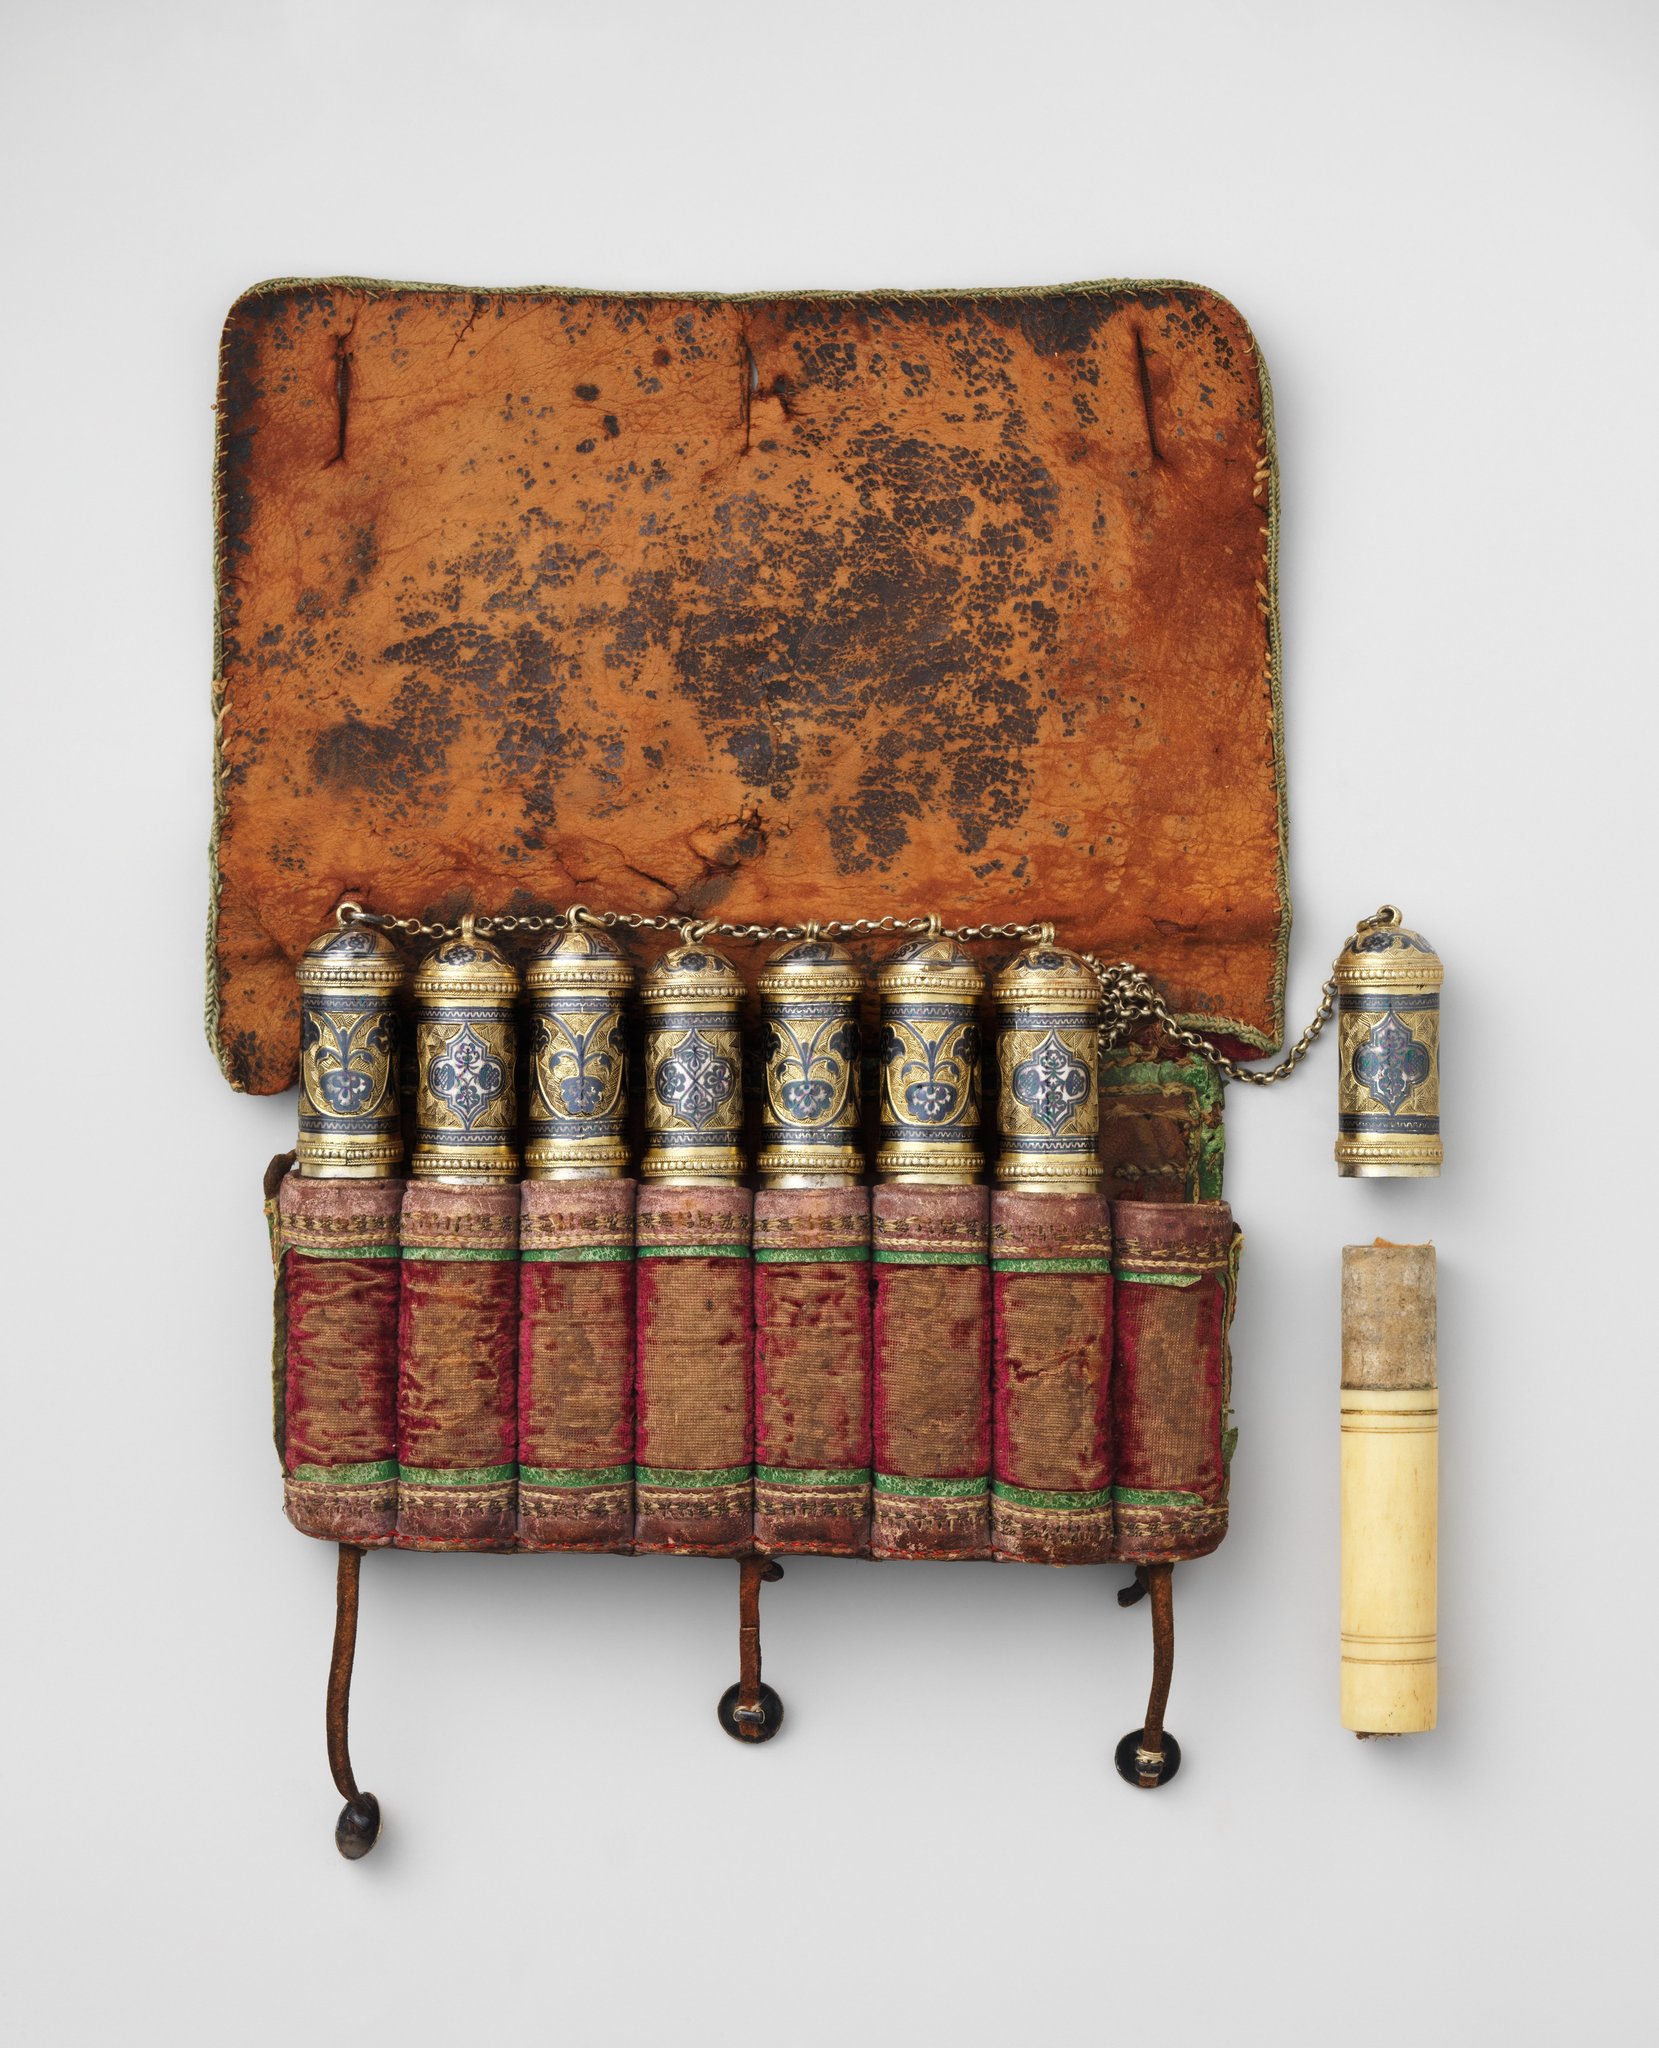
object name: powder charge container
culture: caucasian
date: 1801-1900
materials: ivory, leather, niello, silver, textile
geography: caucasus